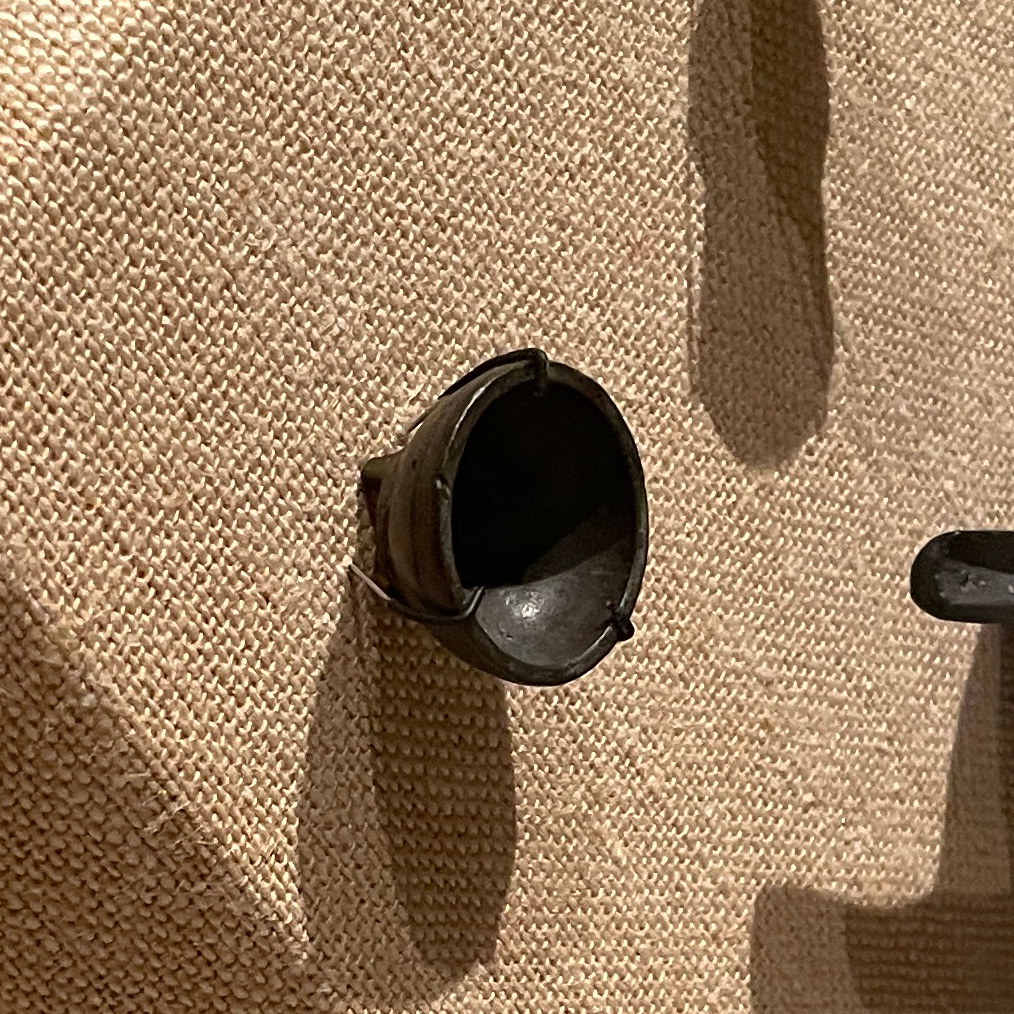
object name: vessel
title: Miniature Vessel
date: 1101-1300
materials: bronze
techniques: incising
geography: iran